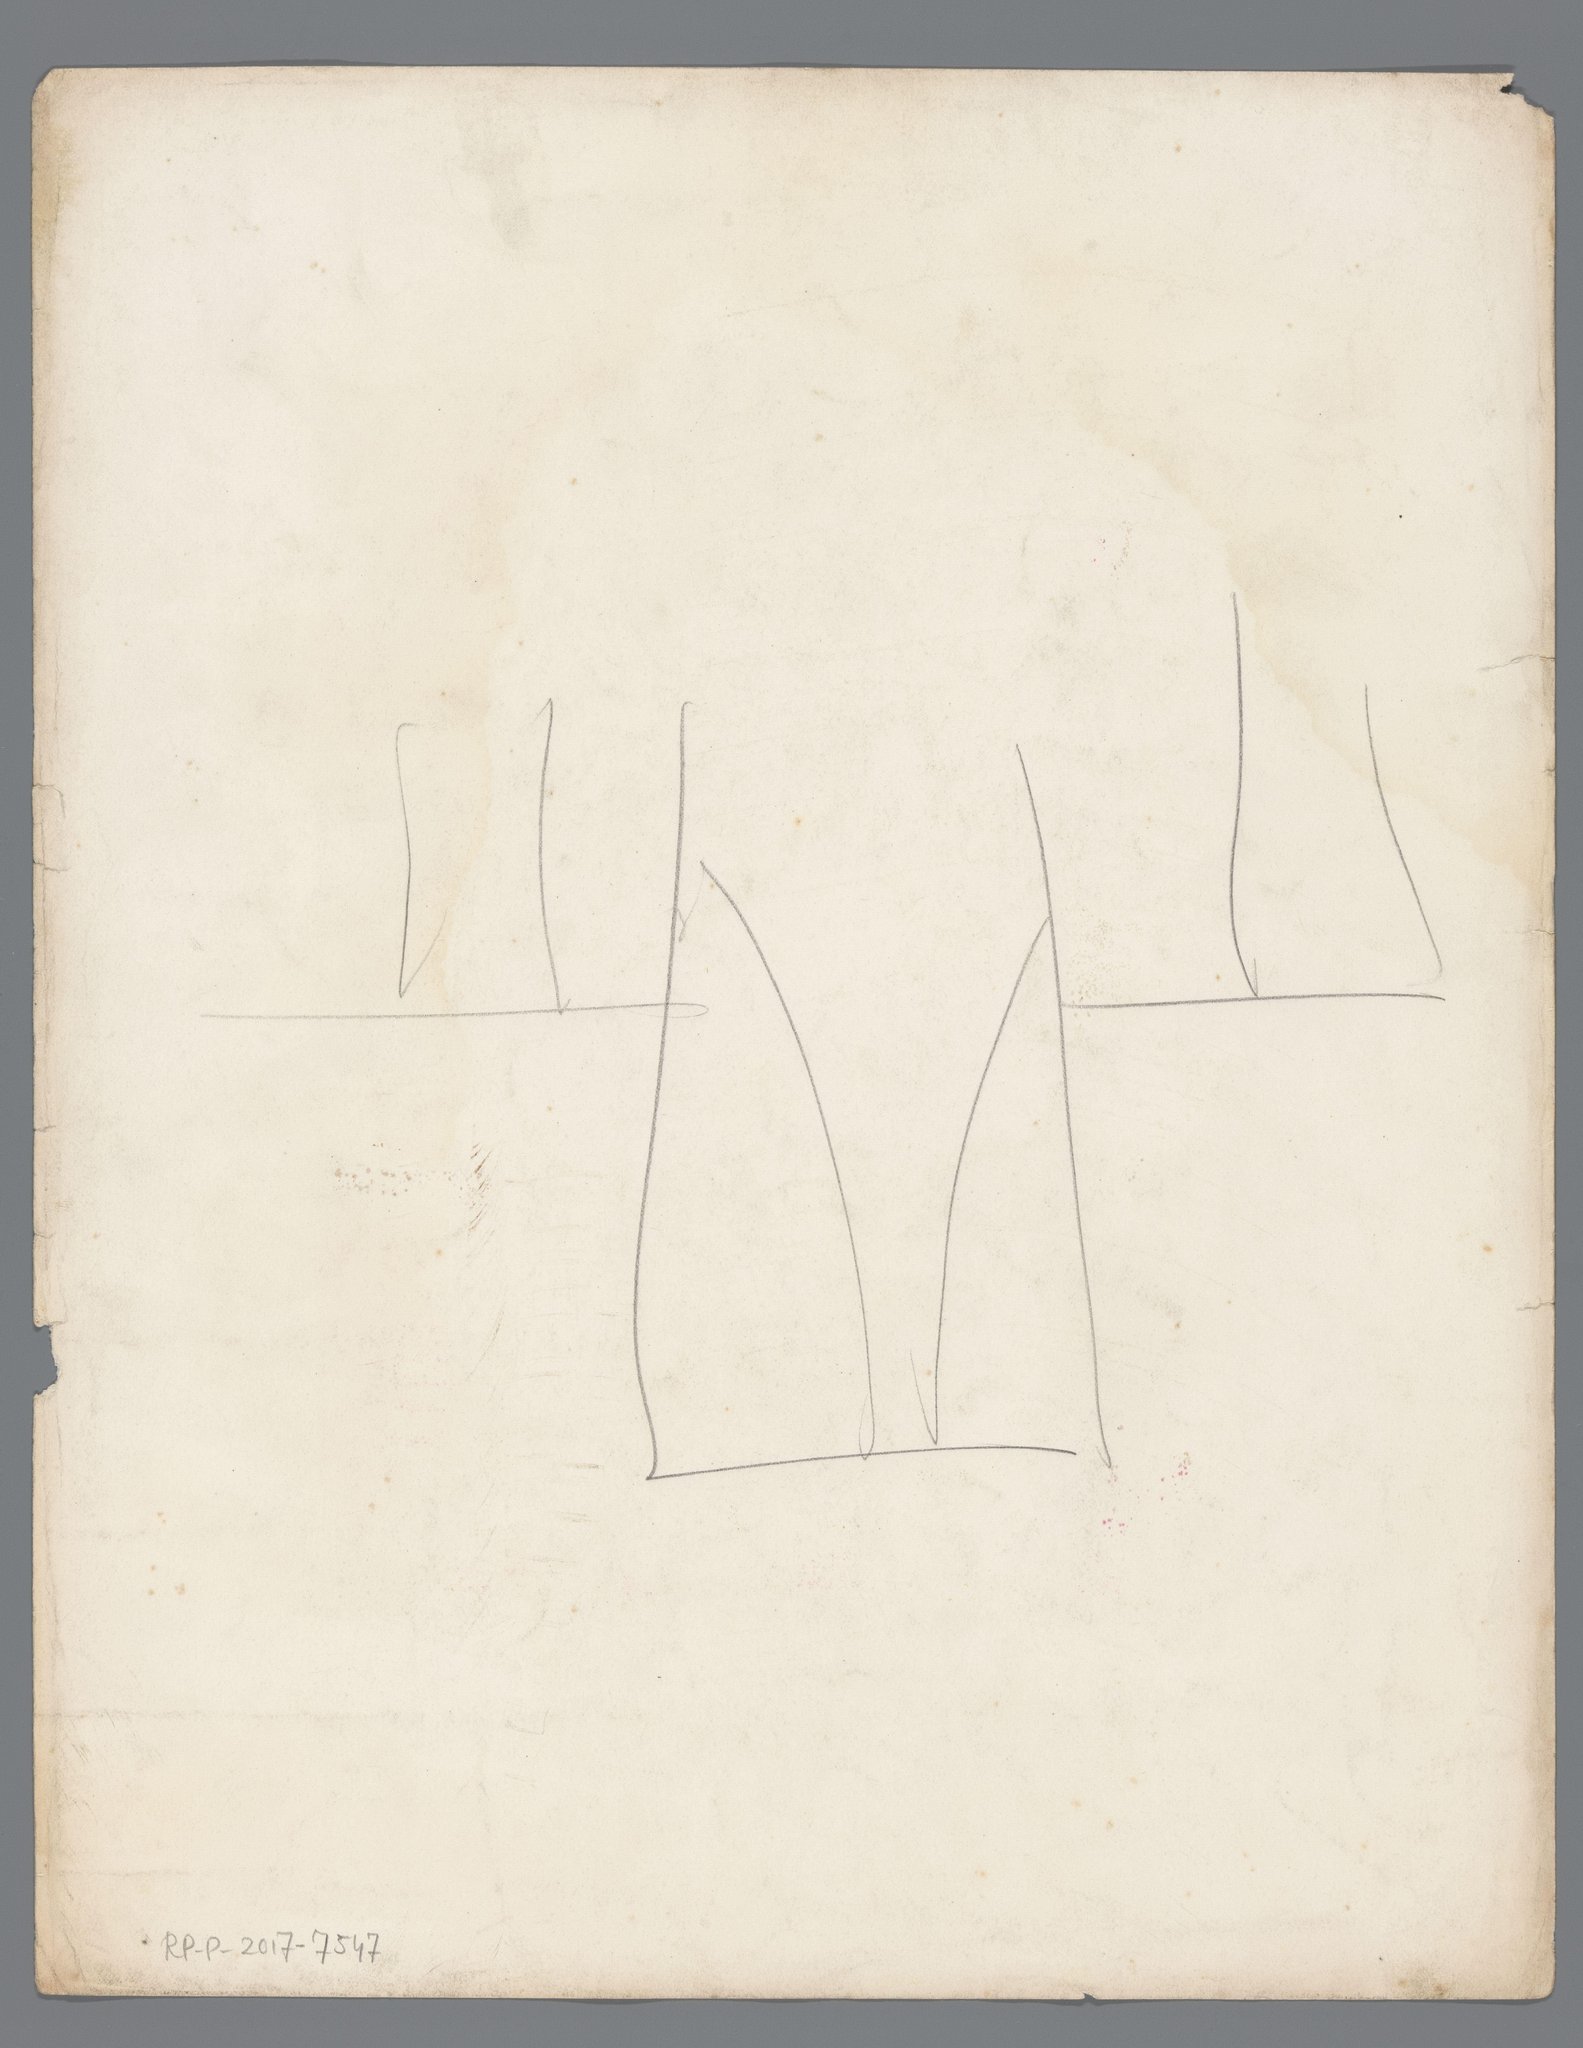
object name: drawing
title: Gordijn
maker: Anonymous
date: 1886-1899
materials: paper, pencil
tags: hangings and drapery